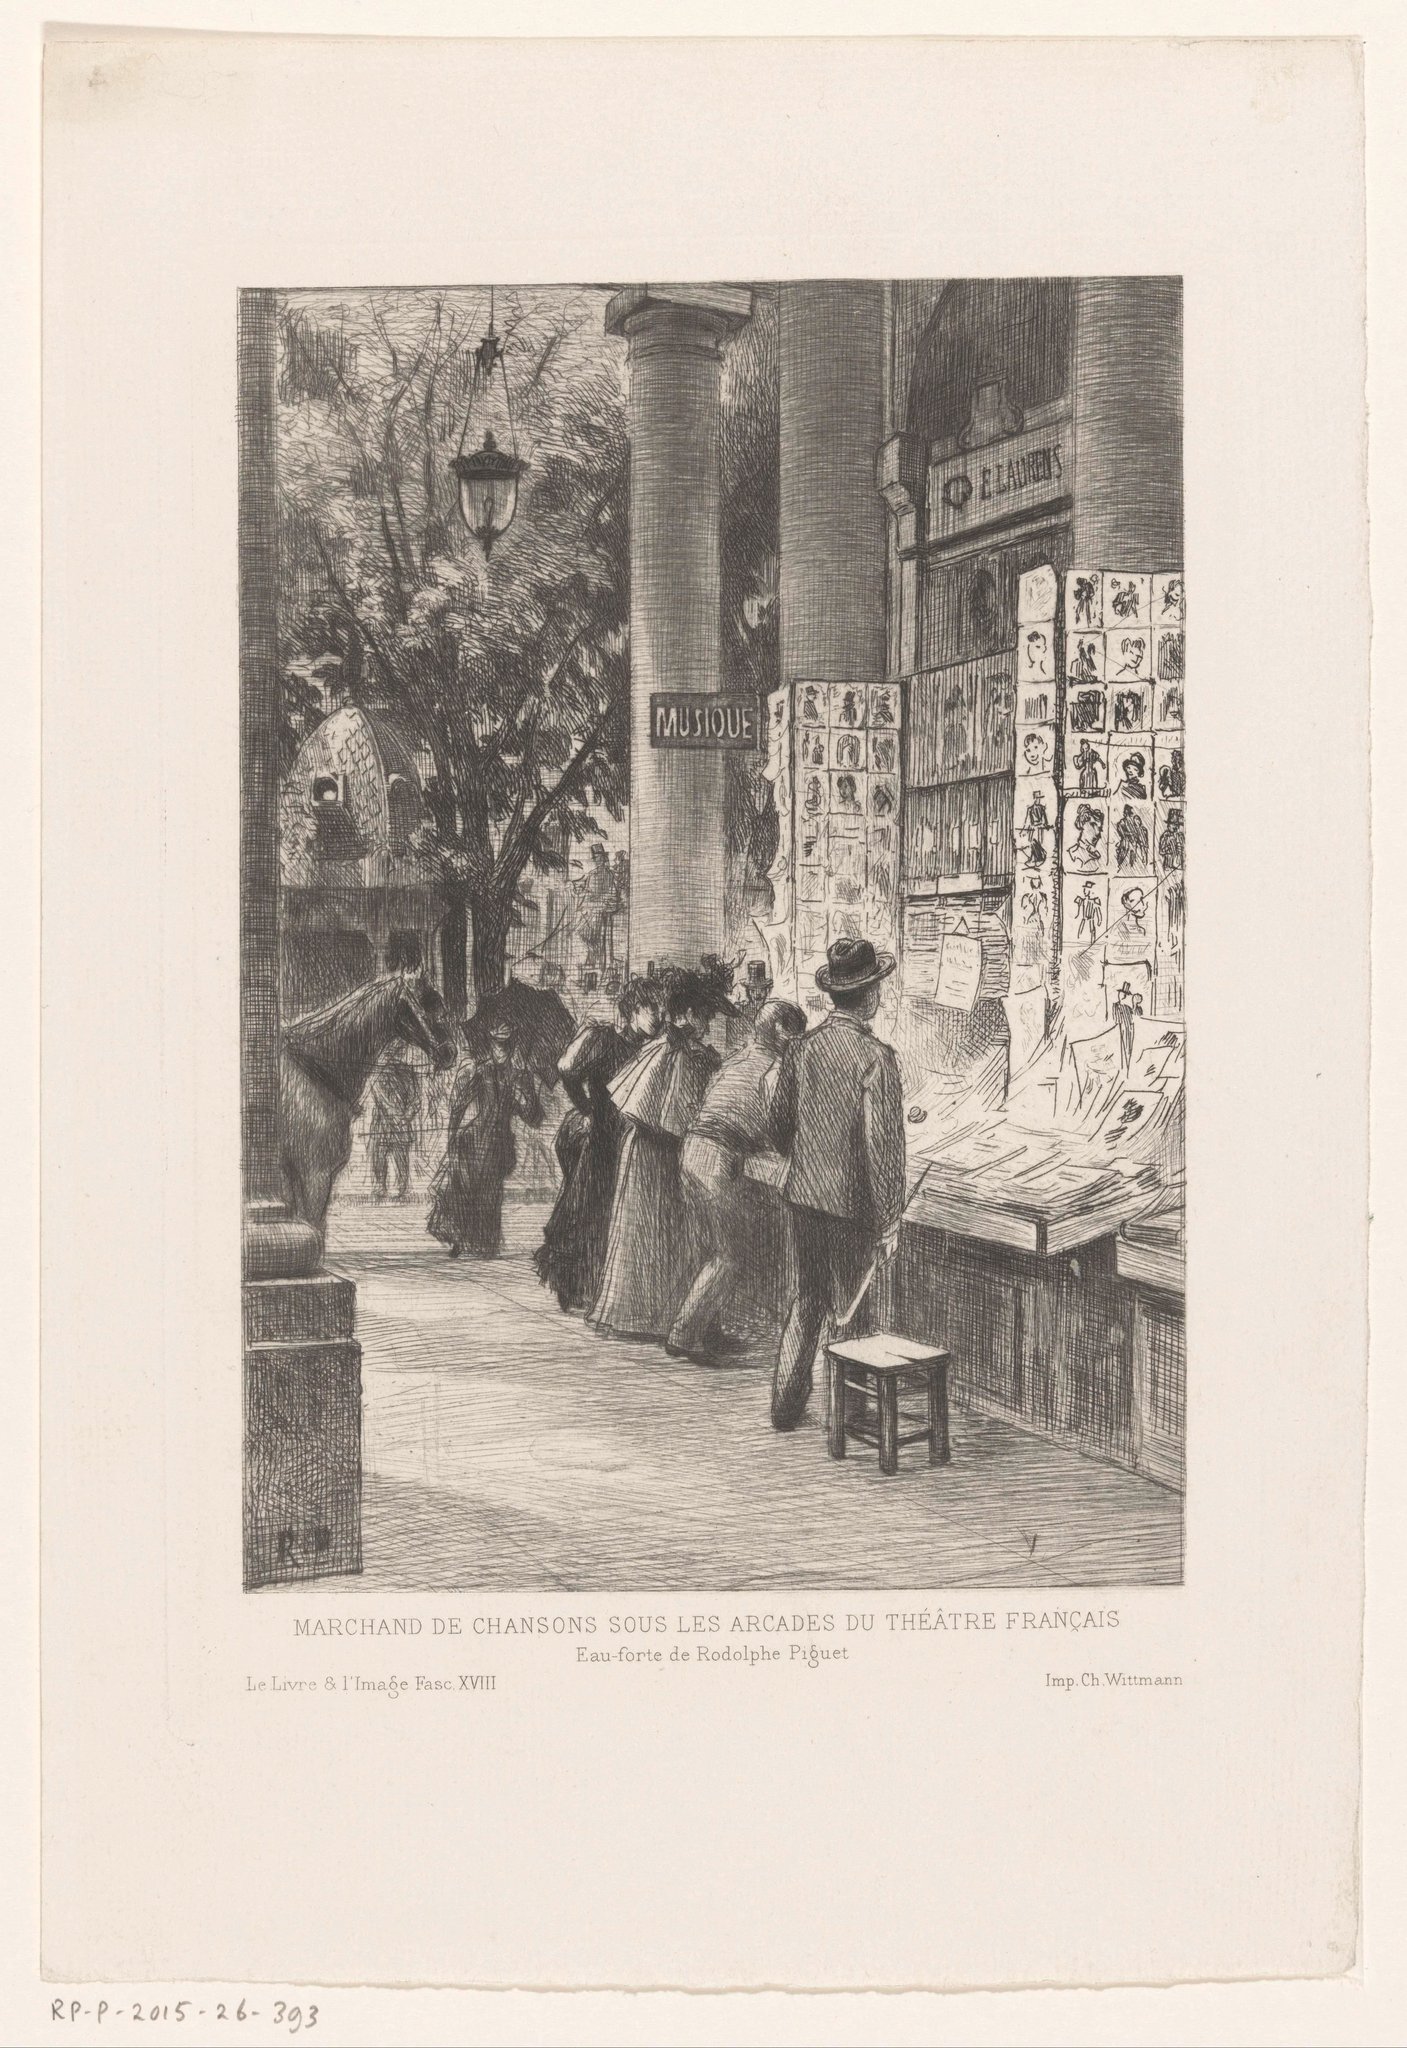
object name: print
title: Liedverkopers onder de galerij van het Théatre Français te Parijs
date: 1893-1910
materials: paper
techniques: drypoint, etching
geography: paris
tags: book-stall, kiosk, colonnade, theatre (building)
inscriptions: collector's mark: Lugt 2228, collector's mark: Lugt 4779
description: Prent afkomstig uit: Le Livre et l'image: revue documentaire illustrée mensuelle Fasc. XVIII.